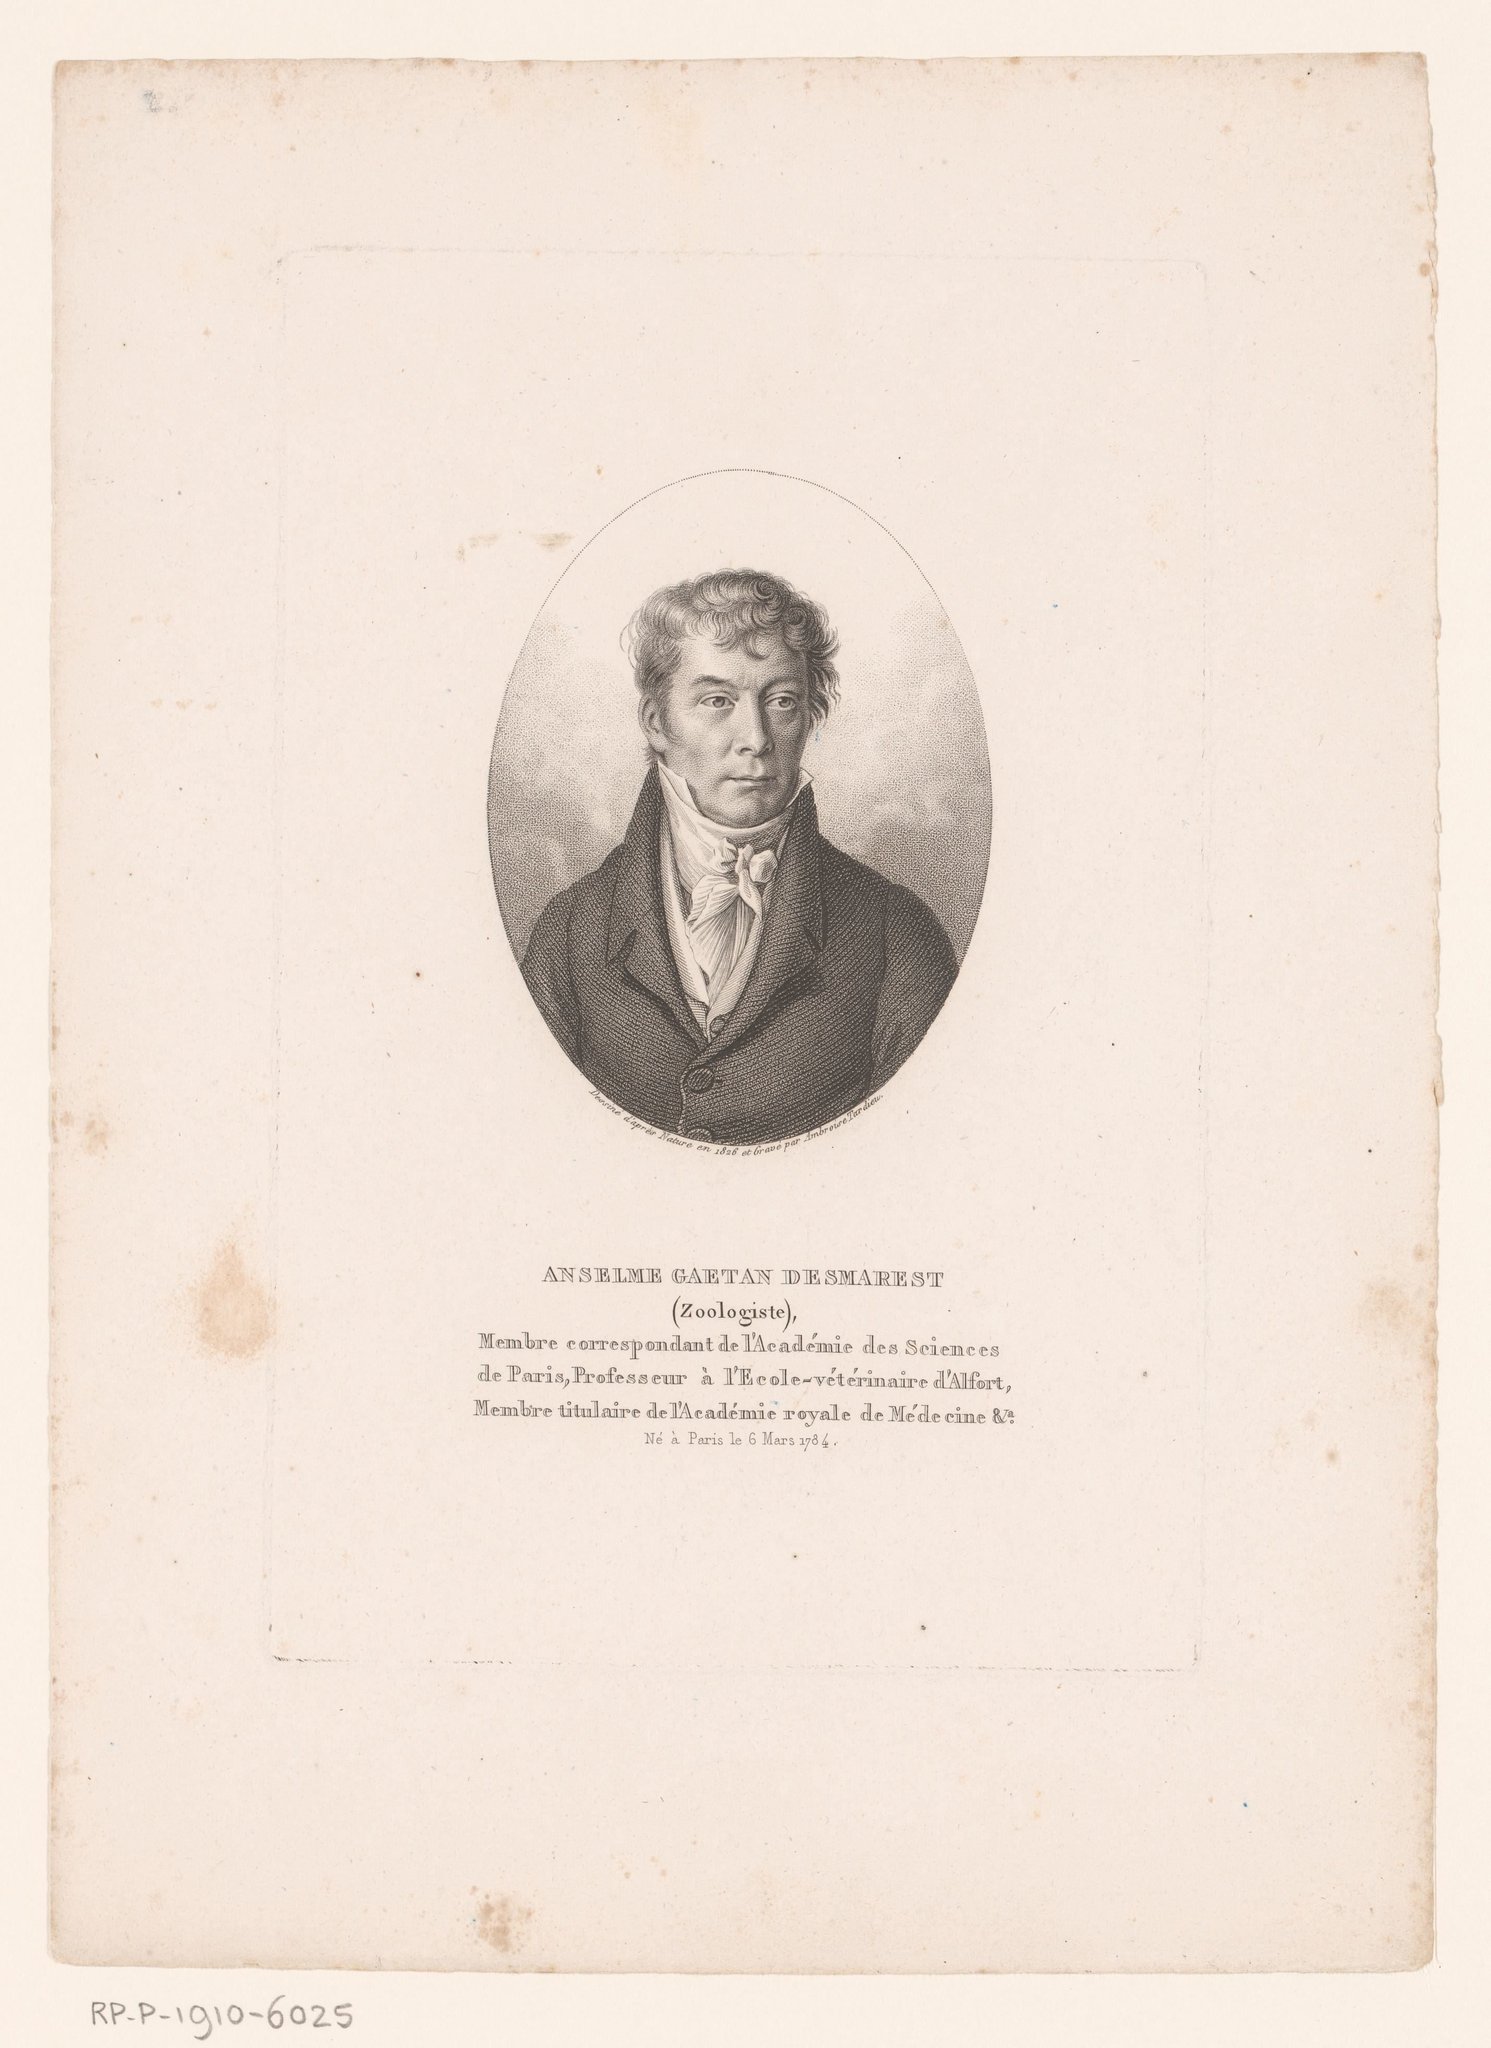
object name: print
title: Collection de tous les personnages célèbres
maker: ambroise tardieu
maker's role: print maker, printer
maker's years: 1788-1841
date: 1826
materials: paper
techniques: engraving, roulette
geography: paris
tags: paris, scholar, philosopher, historical persons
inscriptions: collector's mark: Lugt 2228